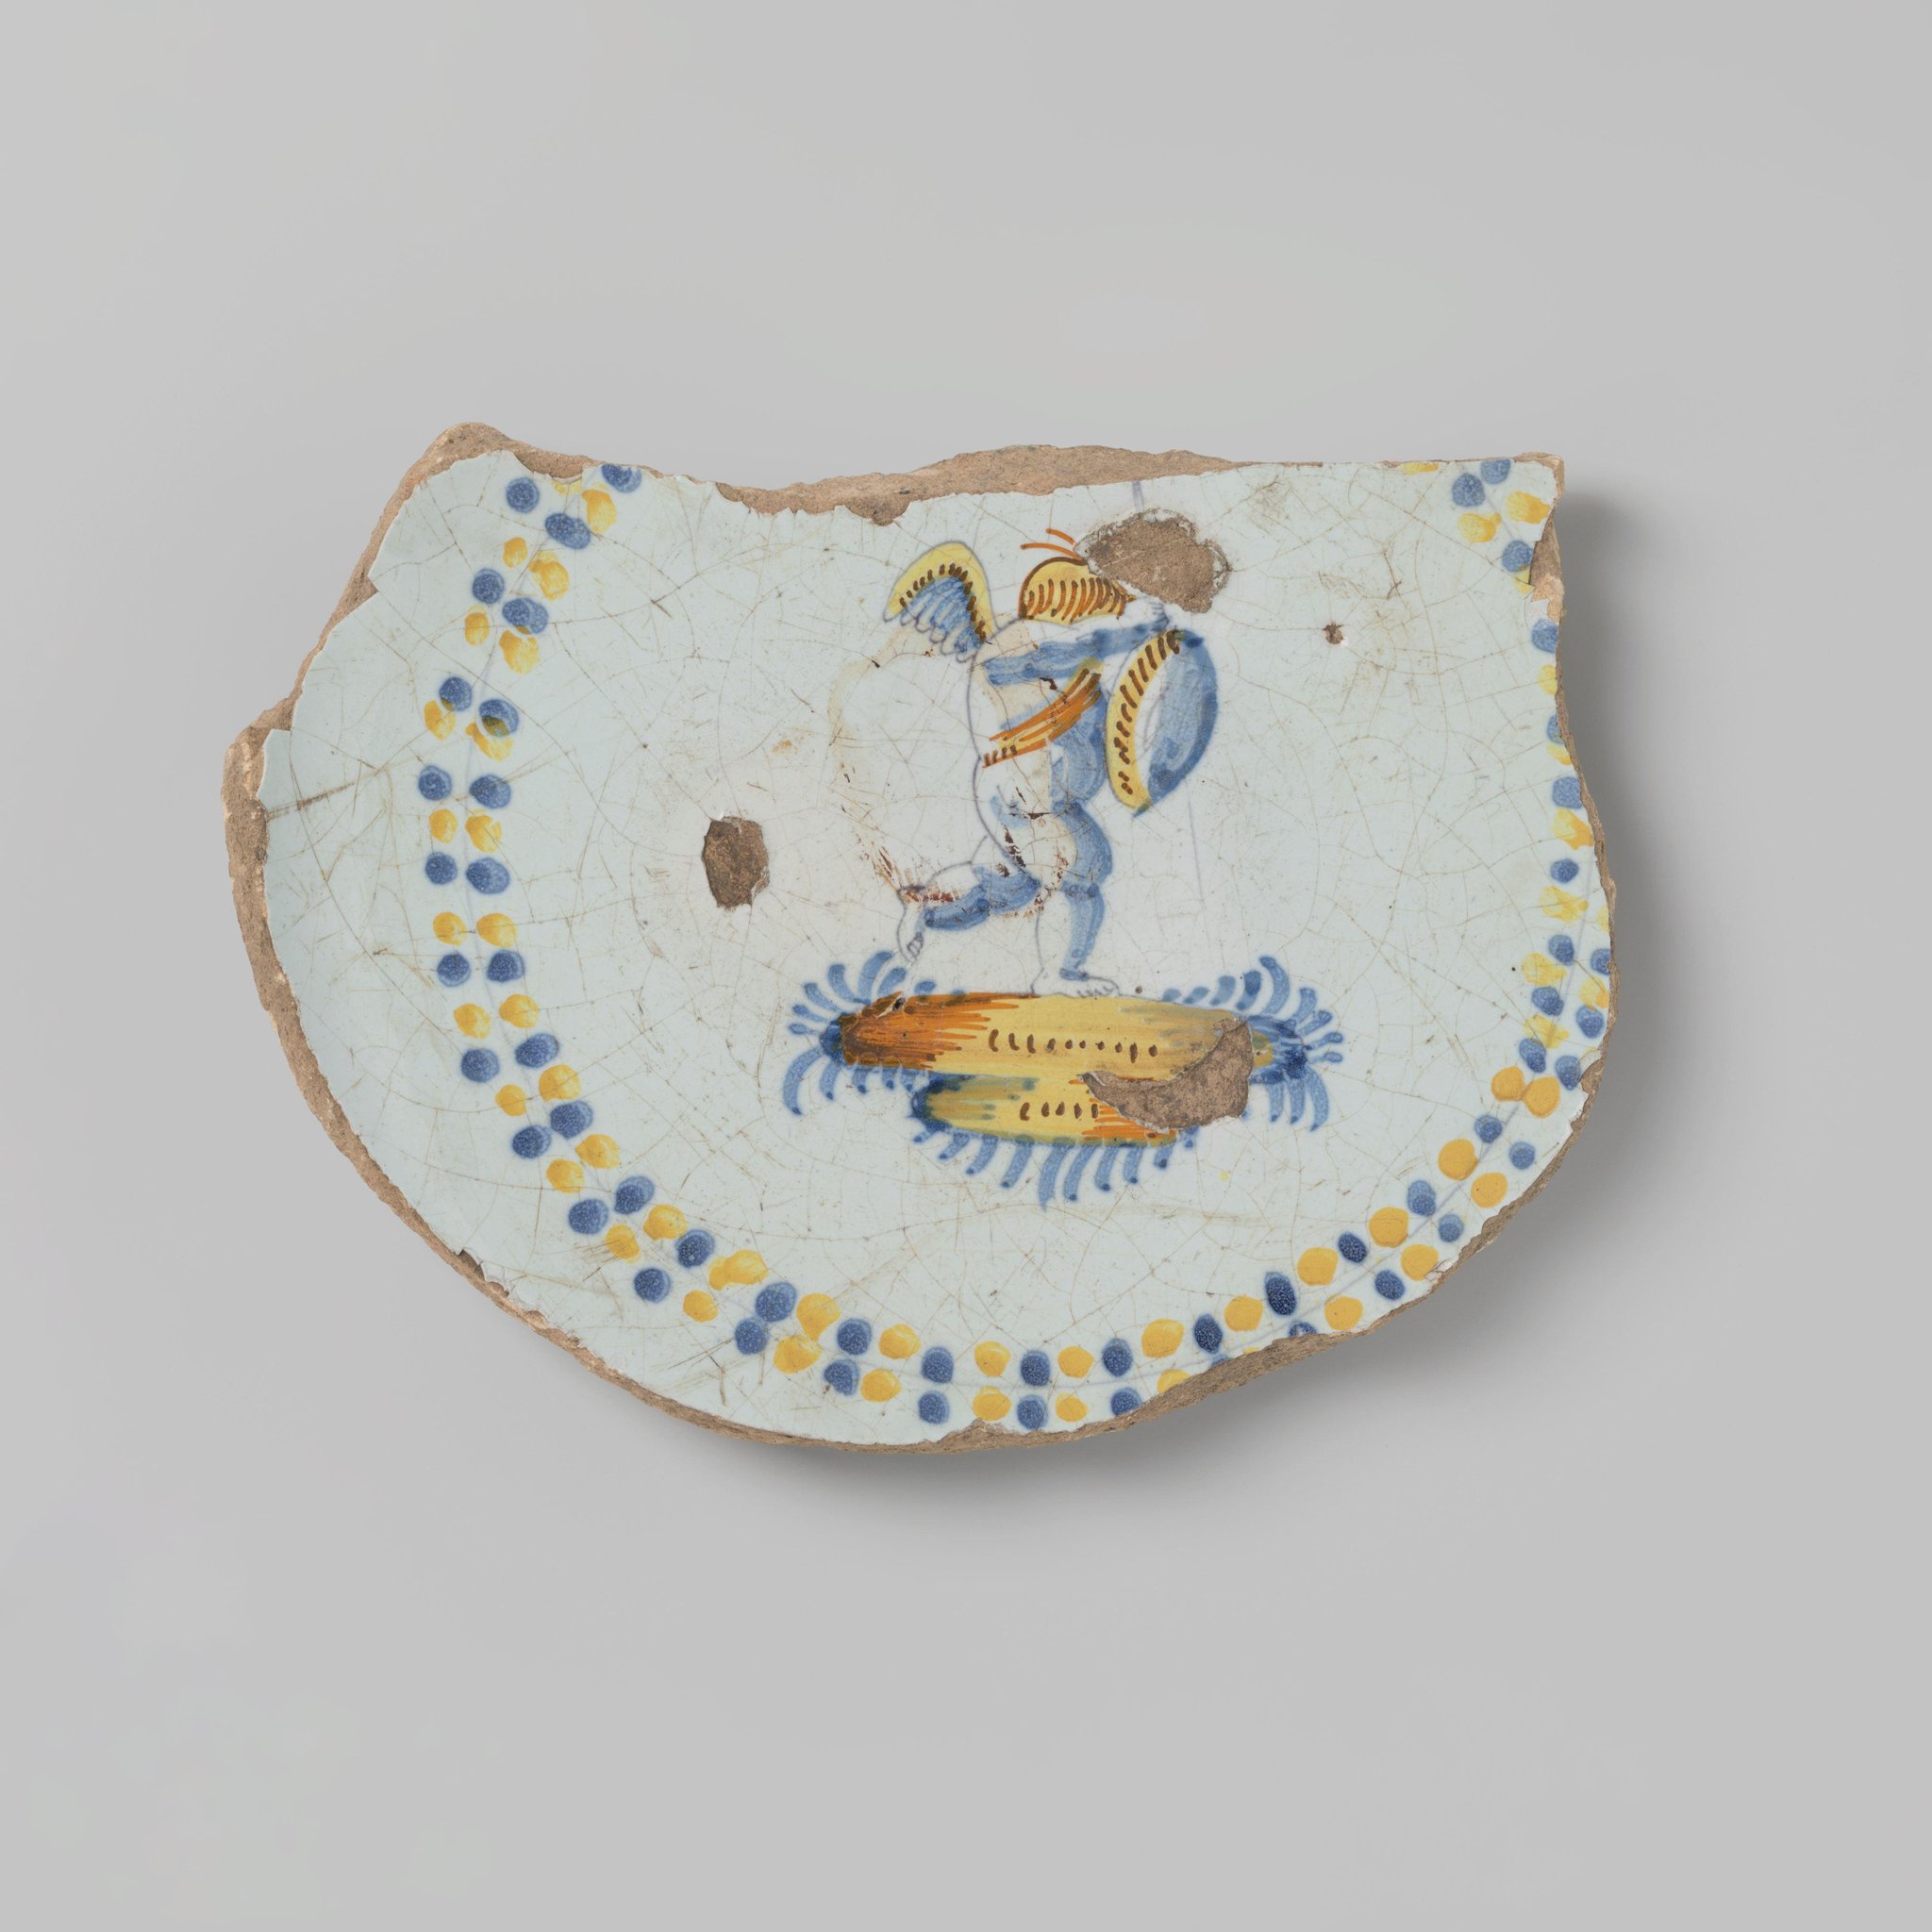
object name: sherd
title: Schotelscherf van aardewerk met veelkleurige tekening van een putto in sierrand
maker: Anonymous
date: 1500-1799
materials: earthenware, glaze